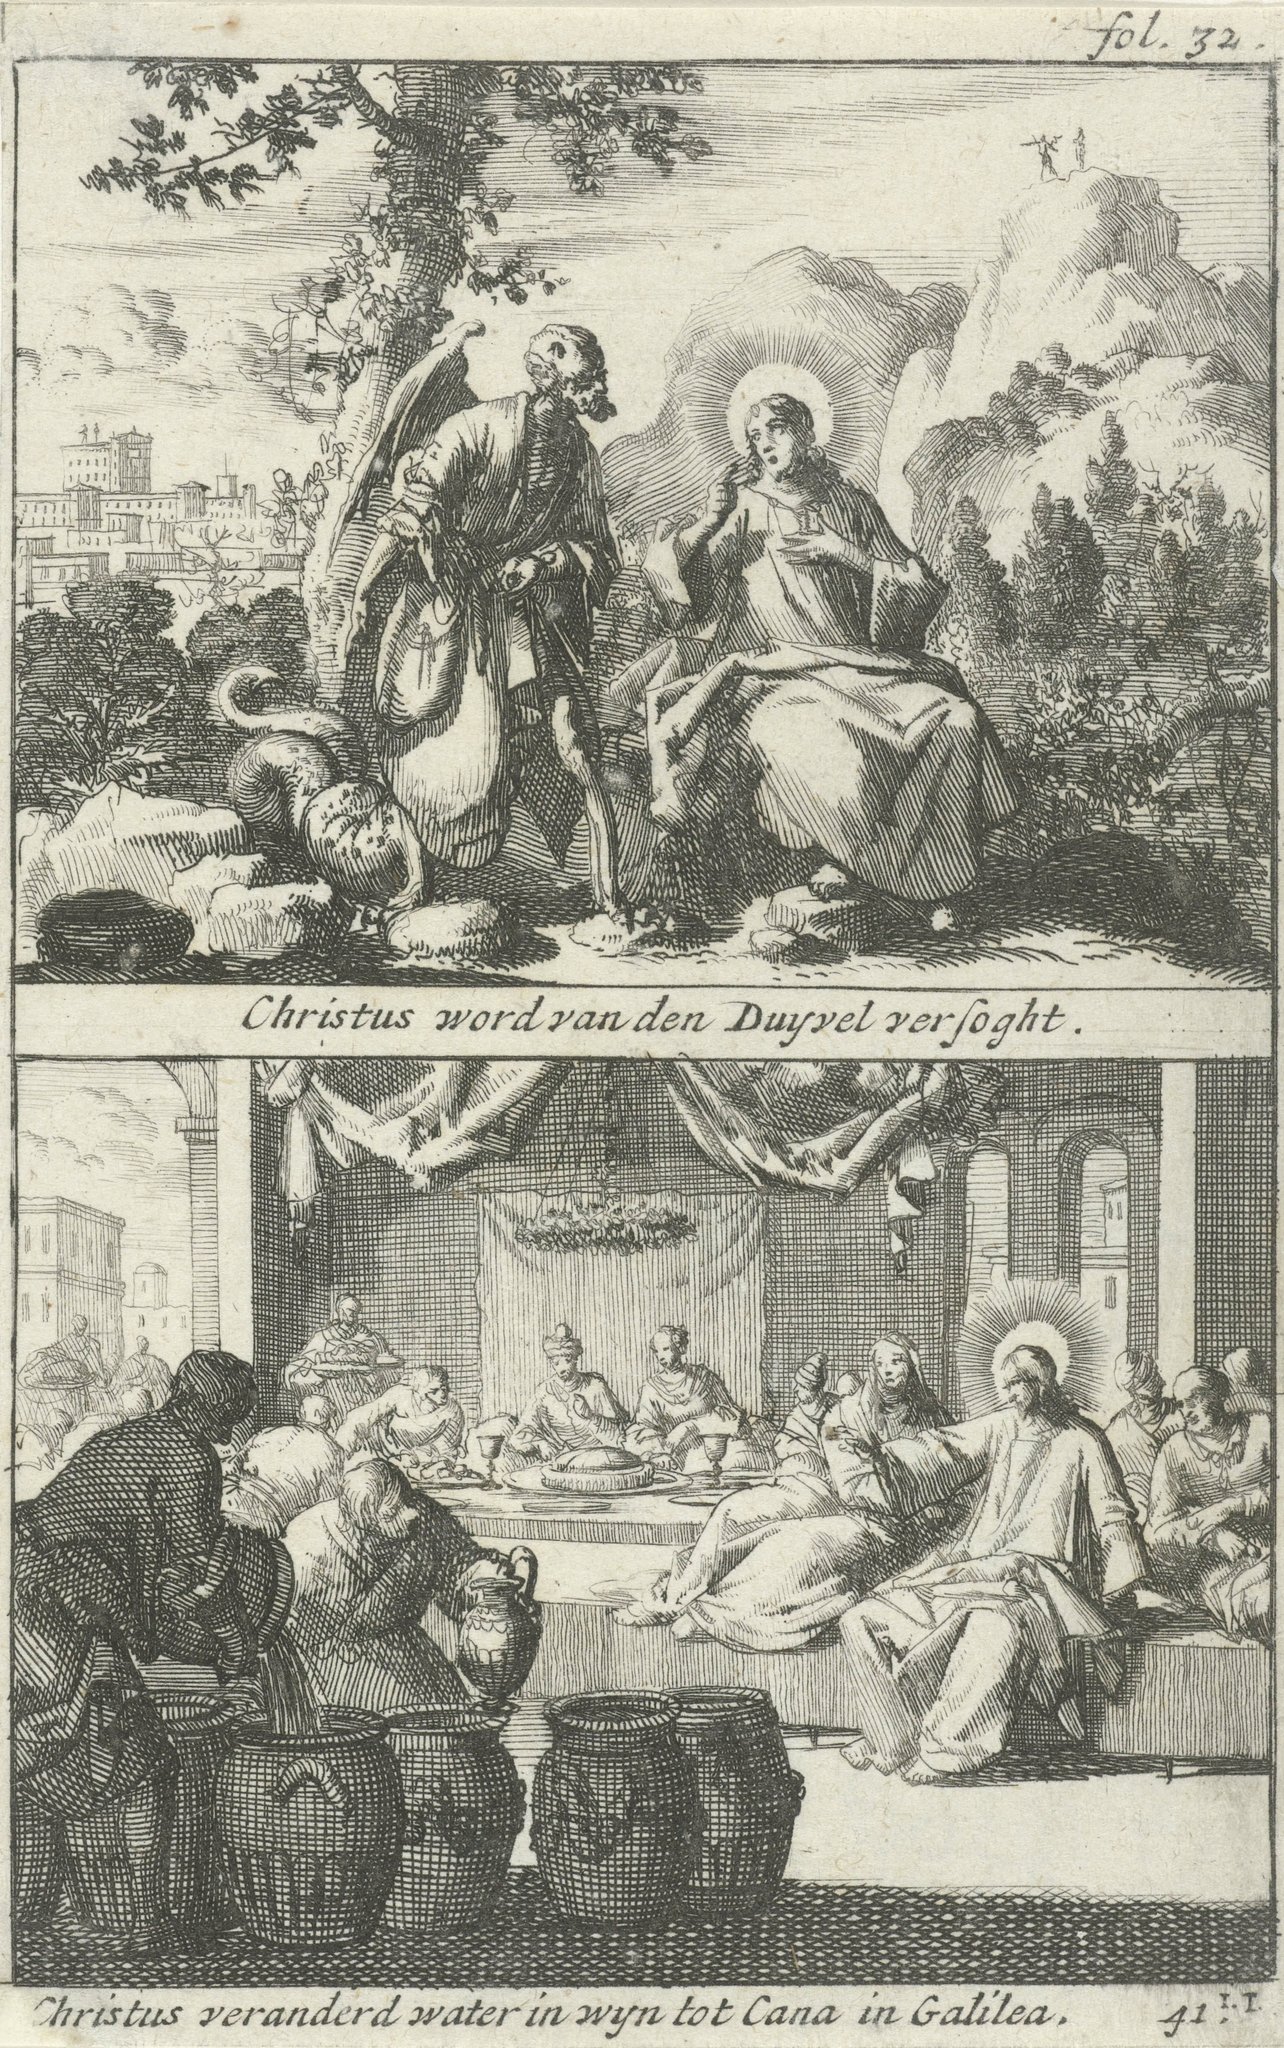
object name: book illustration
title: Christus in verzoeking gebracht door de duivel en de bruiloft te Kana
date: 1690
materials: paper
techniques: etching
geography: amsterdam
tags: christ, sometimes accompanied by guardian angel(s), tempted by satan, who usually appears in human form, the marriage-feast at cana (john 2:1-11)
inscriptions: collector's mark: Lugt 2228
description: Illustratie uit: Garthwait, Henry. Historie des levens en stervens onses Heeren en saligmakers Jesu Christi. Amsterdam: Jan Claesz ten Hoorn, 1690.